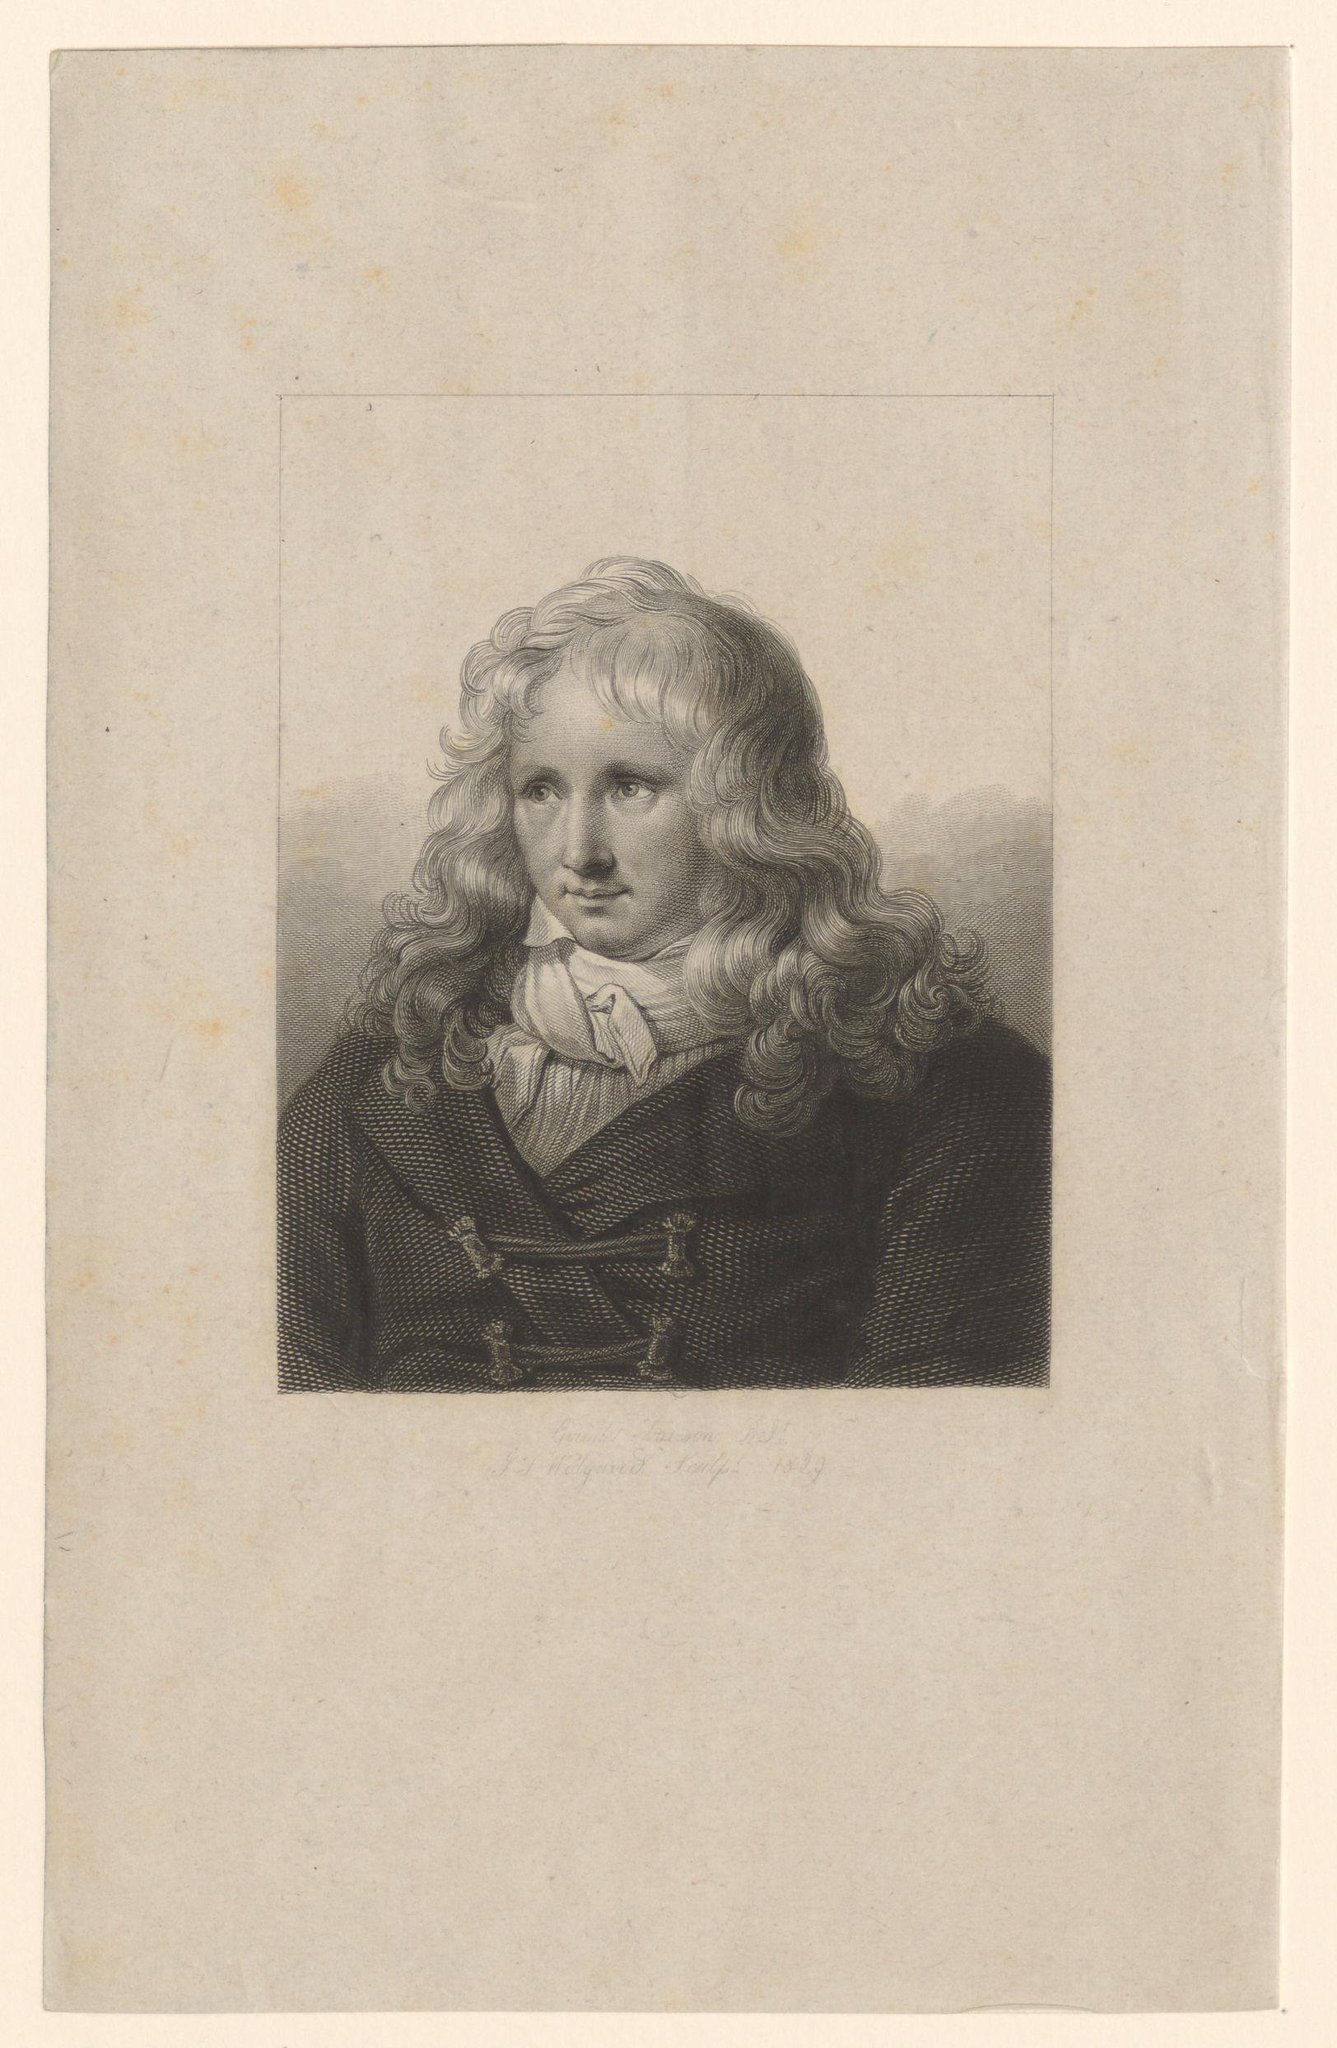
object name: print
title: Portret van een Jacques-Henri Bernardin de Saint-Pierre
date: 1829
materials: paper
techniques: engraving, etching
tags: historical persons, portrait of a writer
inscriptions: collector's mark: Lugt 2228